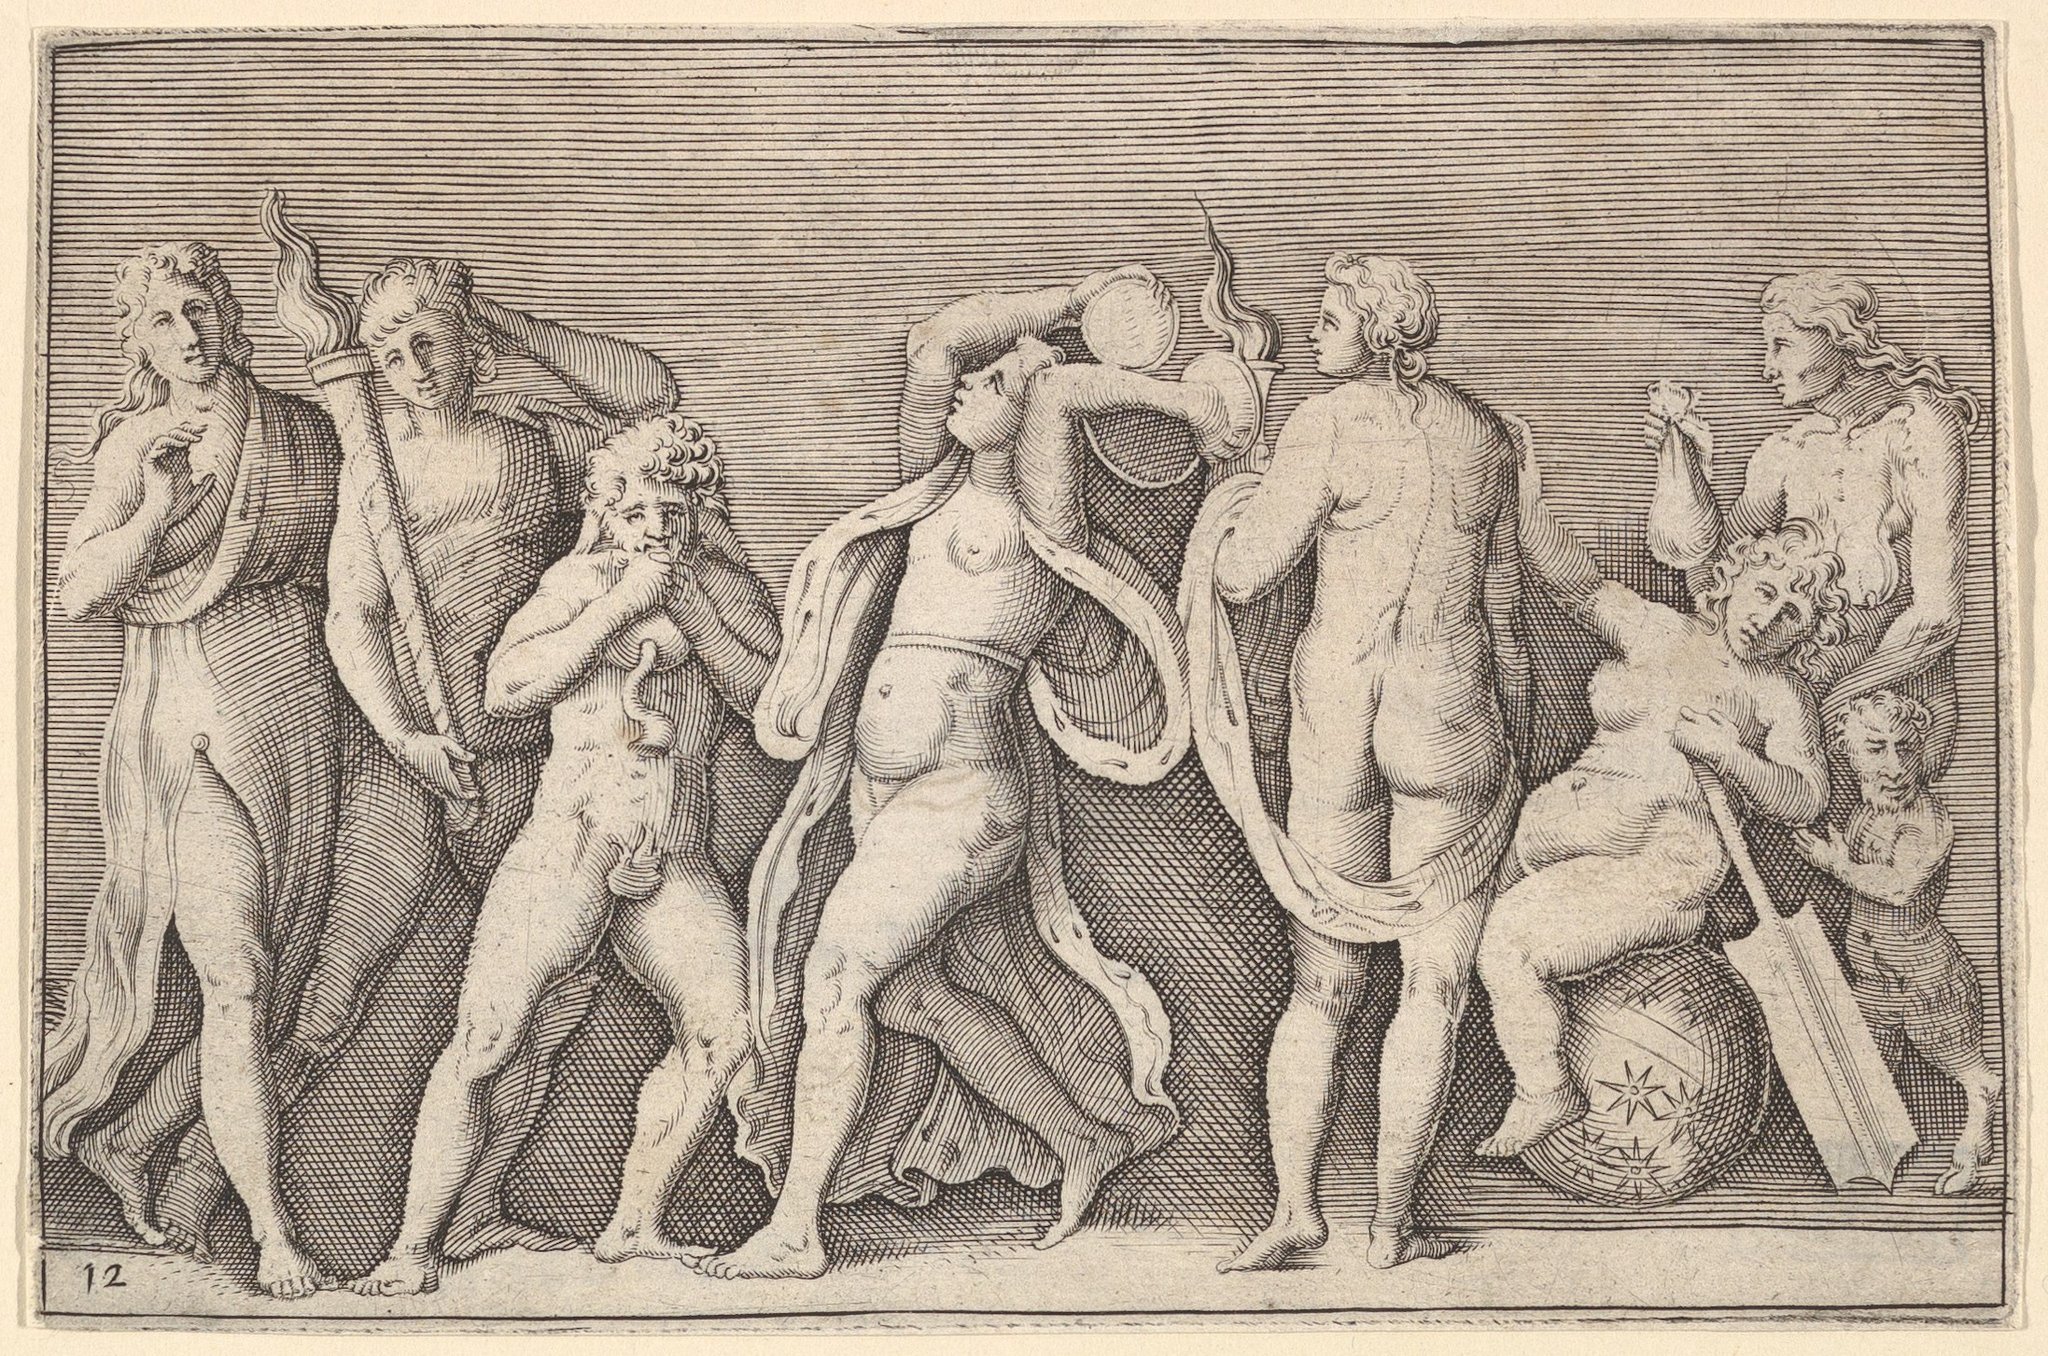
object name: print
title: Bacchanale with Eight Figures, from "Ex Antiquis Cameorum et Gemmae Delineata/ Liber Secundus/et ab Enea Vico Parmen Incis"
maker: anonymous, italian, 16th century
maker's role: artist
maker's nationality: italian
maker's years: 1500-1600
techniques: engraving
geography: rome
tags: male nudes,female nudes